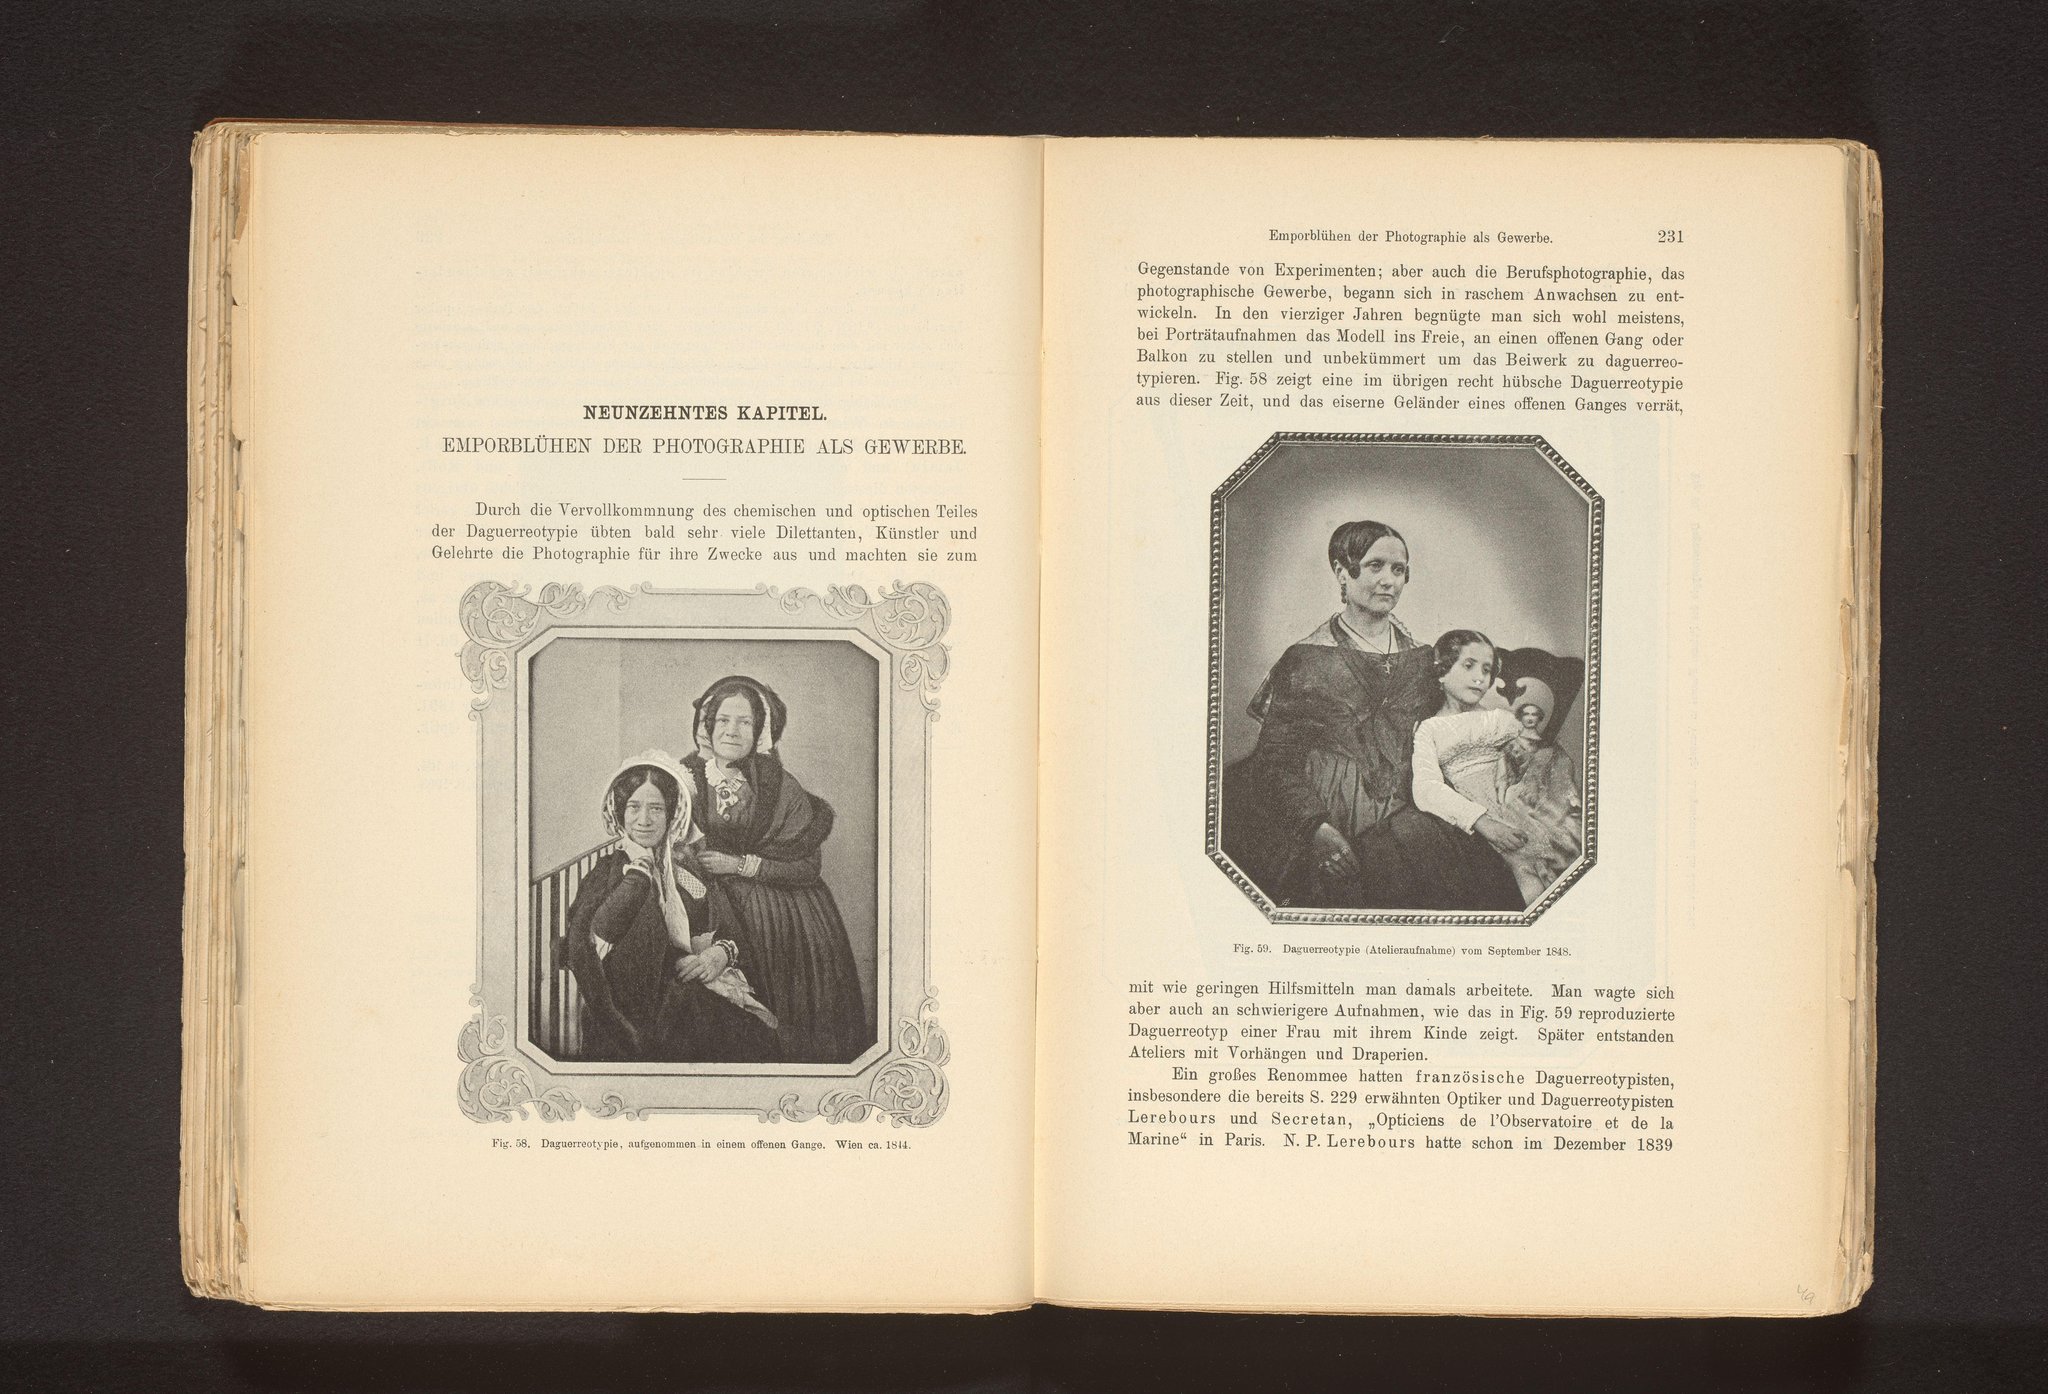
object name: photomechanical print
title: Daguerreotypie (Atelieraufnahme) vom September 1848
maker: Anonymous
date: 1900-1905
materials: paper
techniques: autotype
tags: mother and daughter(s) (family group)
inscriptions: number: ‘Fig. 59.’